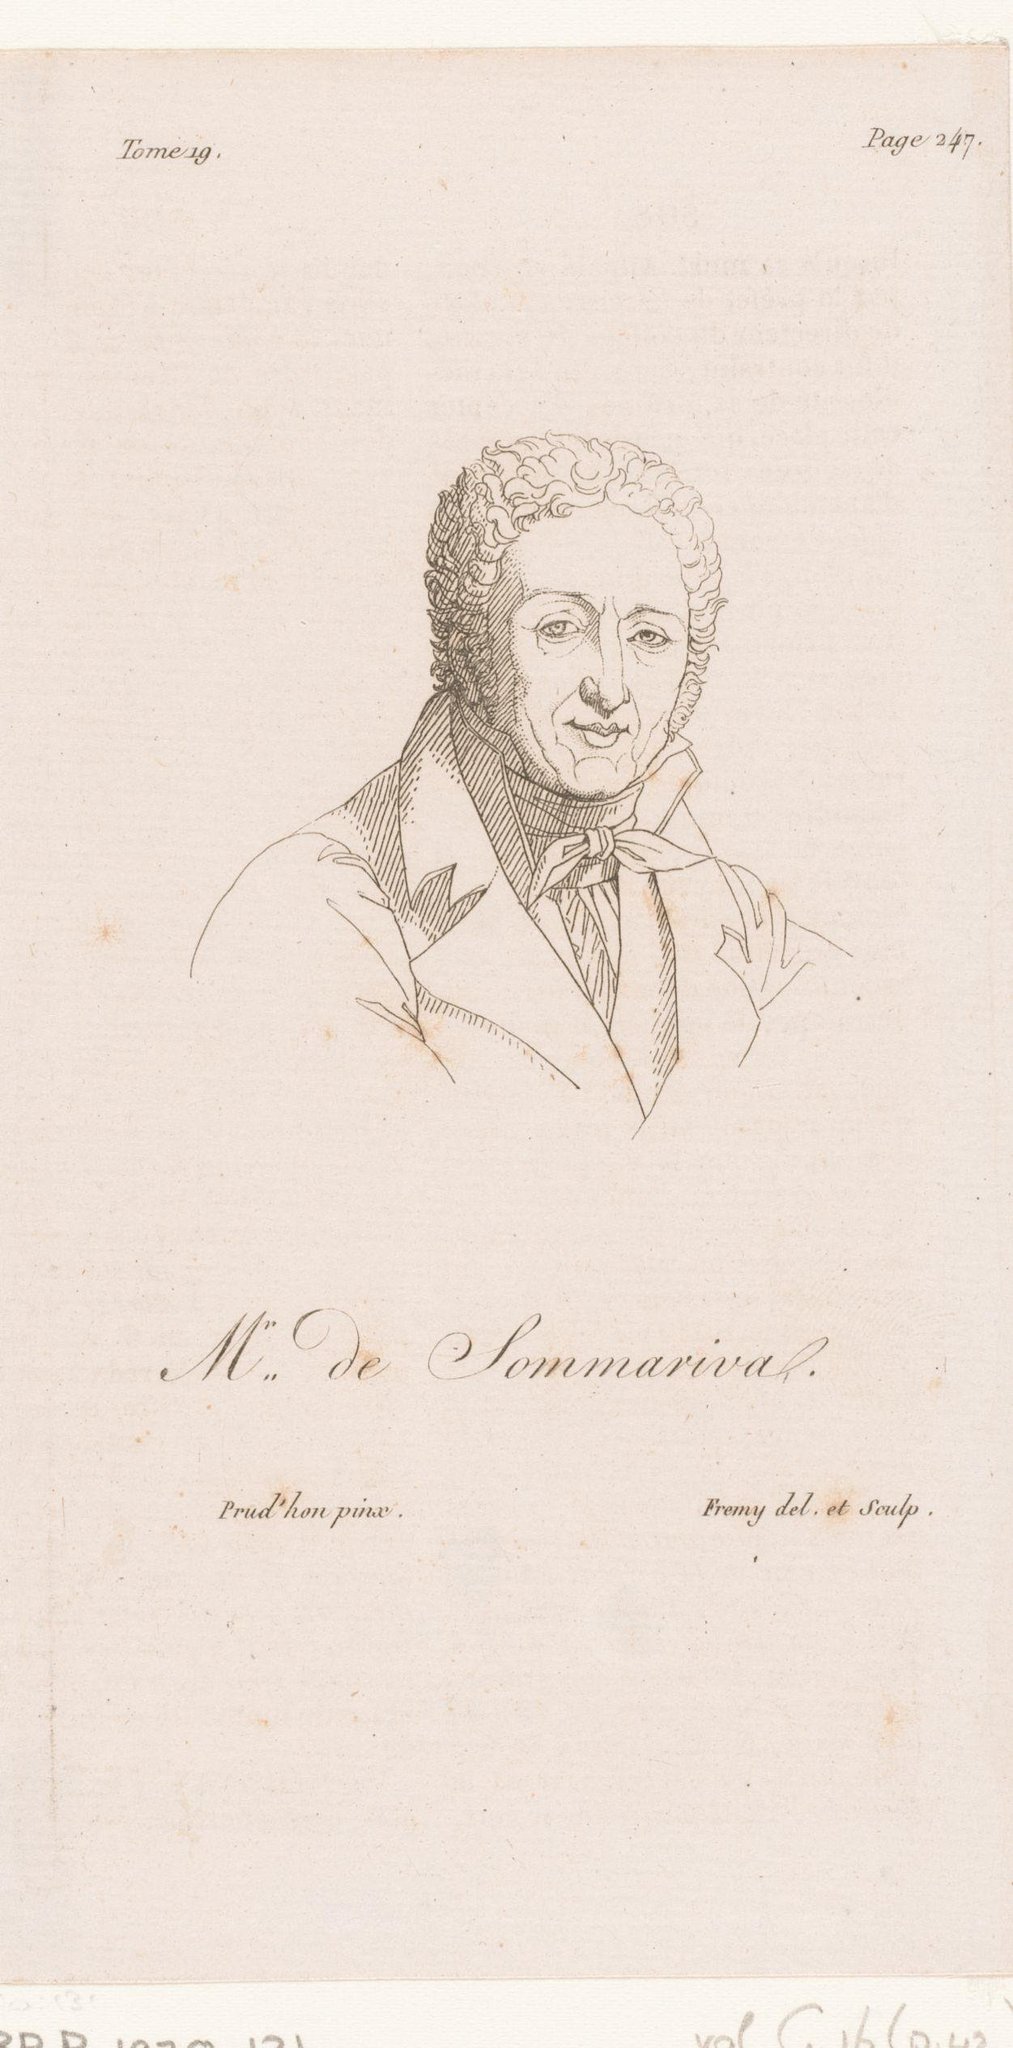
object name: print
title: Portret van Gian Battista Sommariva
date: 1792-1867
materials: paper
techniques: etching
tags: politician, historical persons, politician, e.g. party leader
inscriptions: collector's mark: Lugt 2760, collector's mark: Lugt 2228a